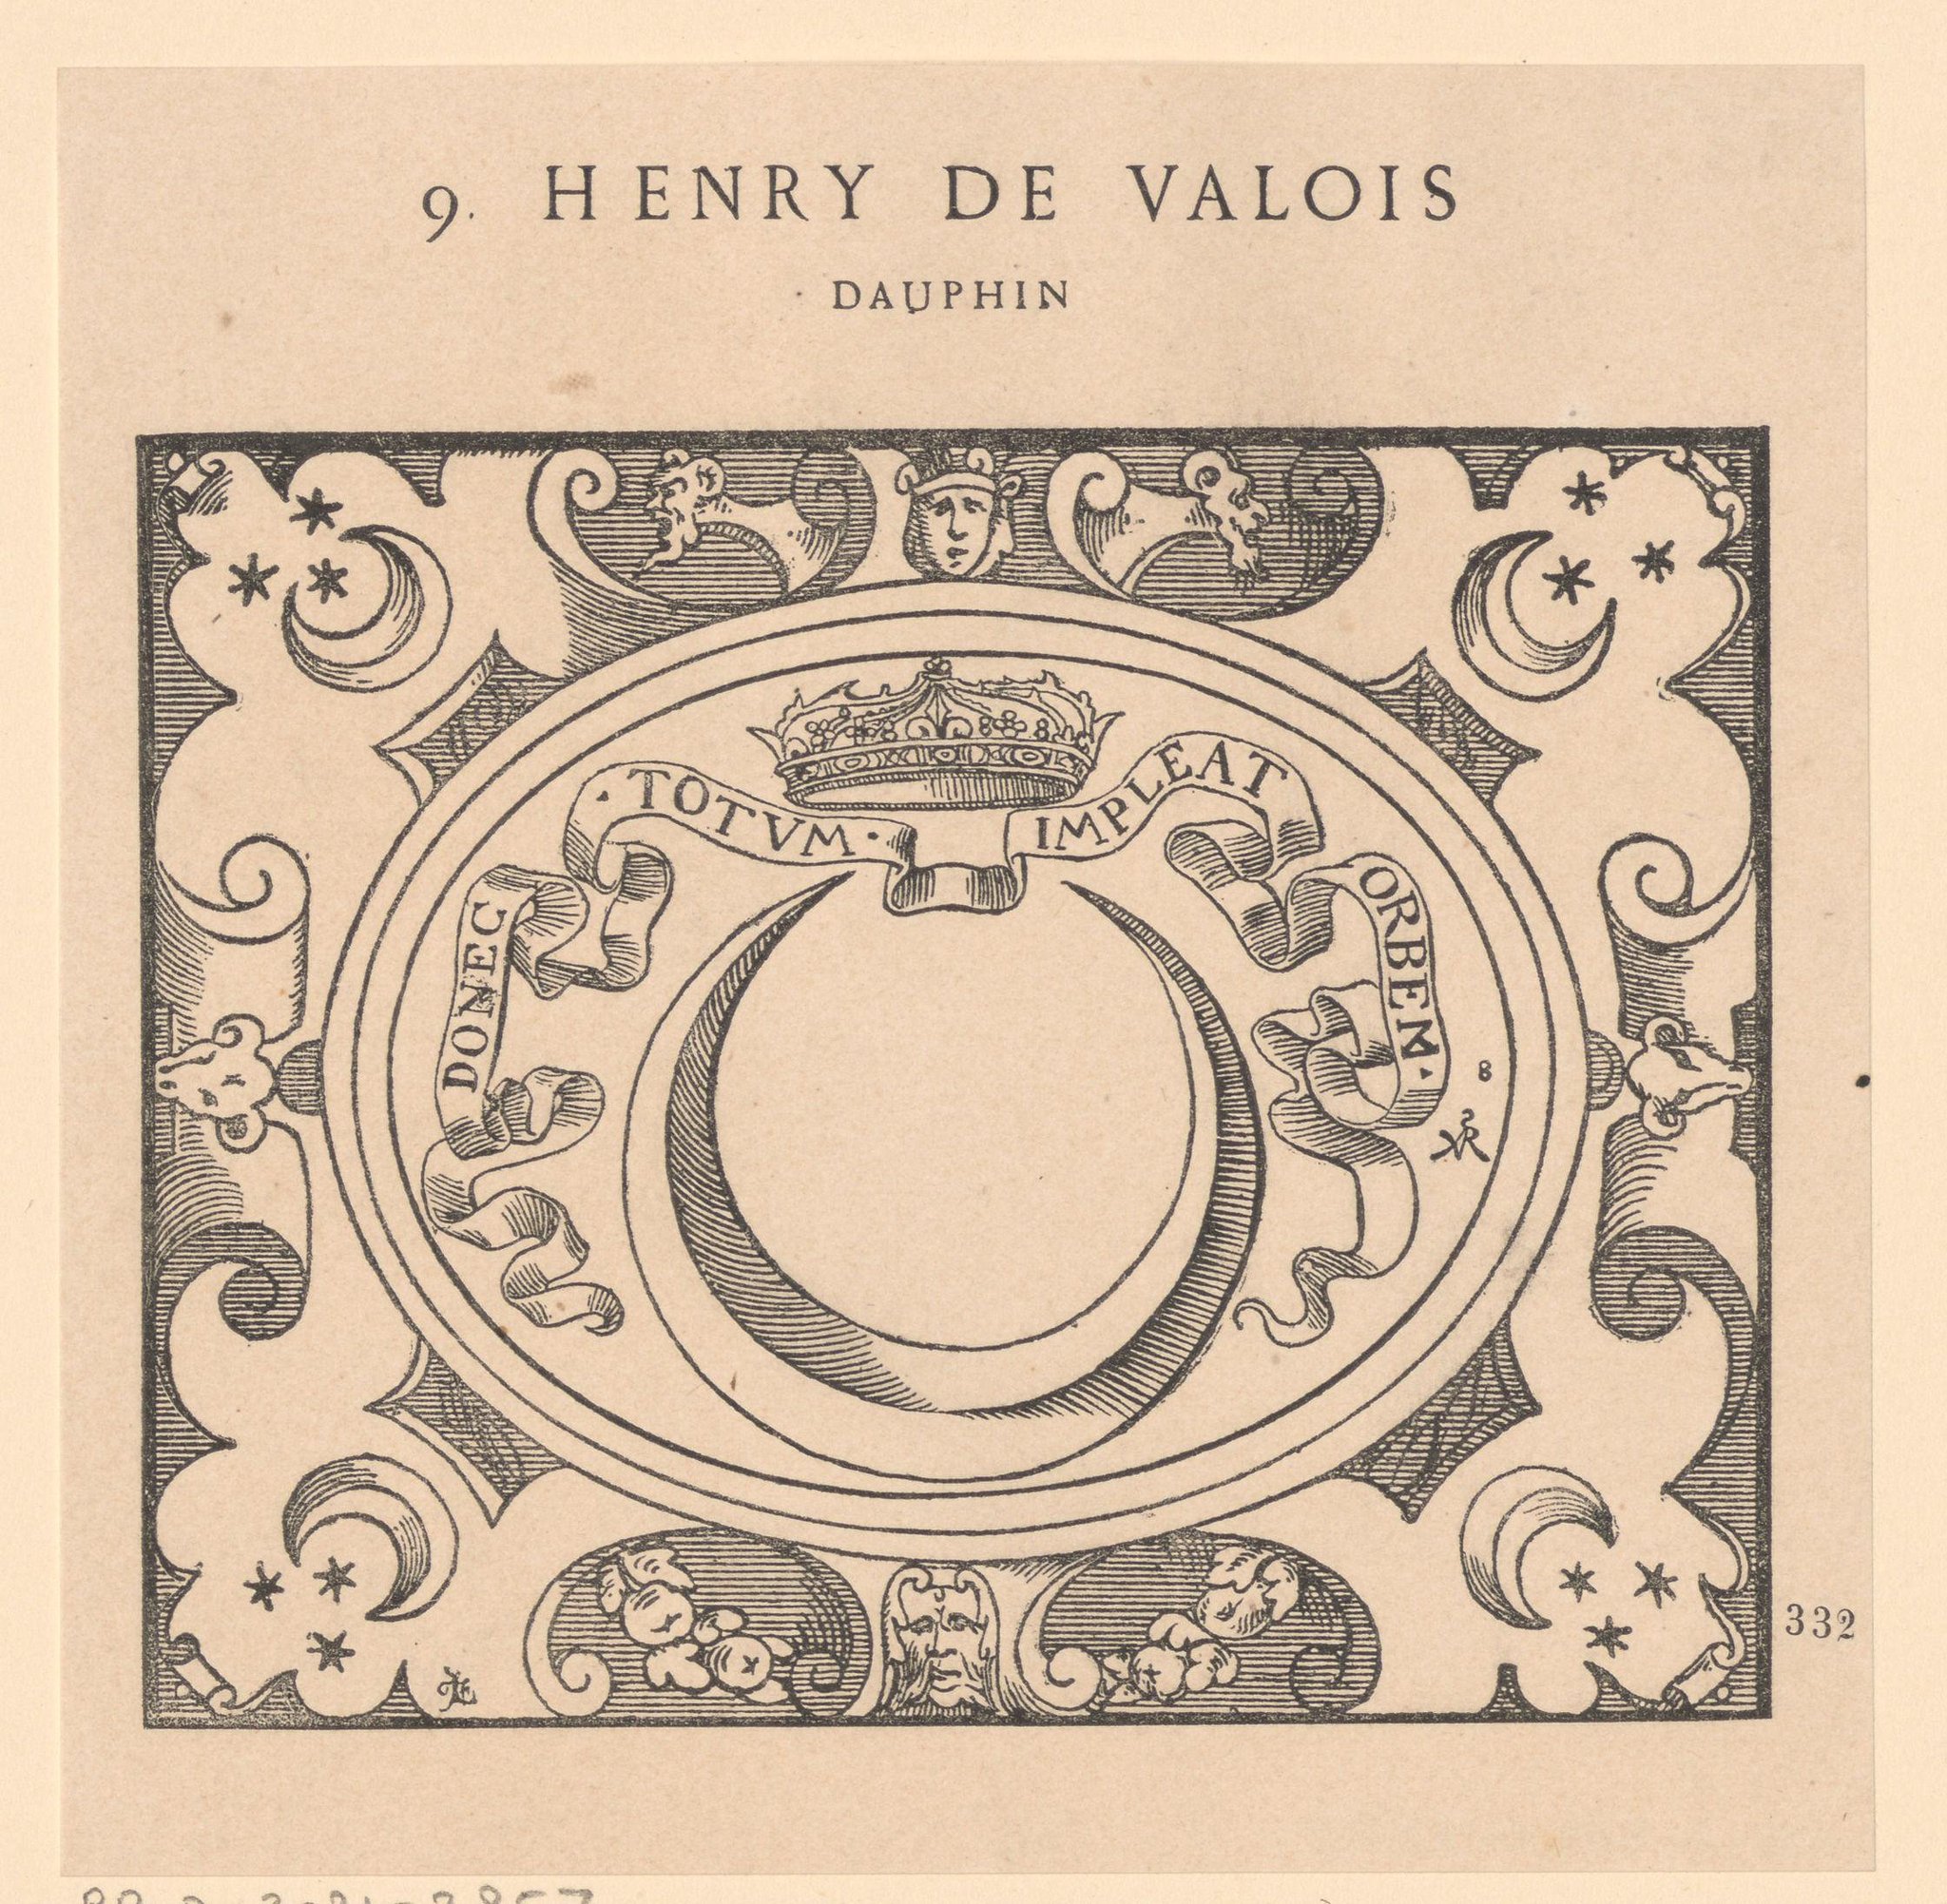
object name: photomechanical print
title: Embleem van Hendrik II, koning van Frankrijk, als dauphin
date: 1862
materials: paper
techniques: letterpress printing, printing block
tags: paris, crown (symbol of sovereignty), waxing moon represented as face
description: Prent uit: L'Art pour tous, nr. 44, 10 juli 1862.